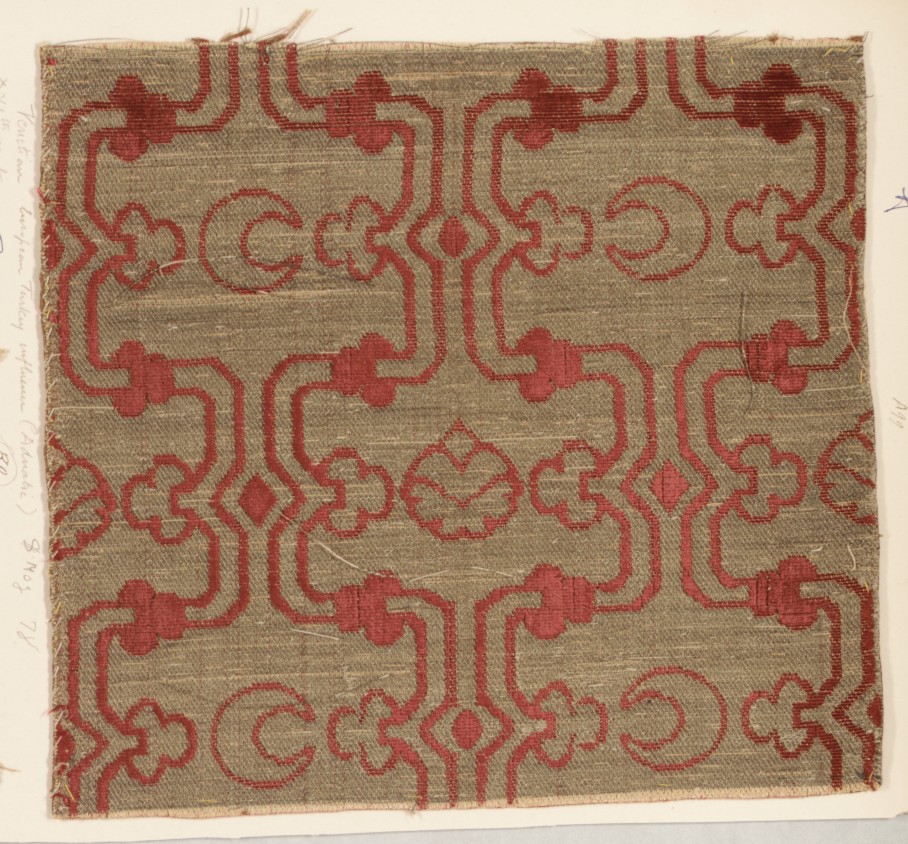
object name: fragment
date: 1501-1600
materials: metal thread, silk